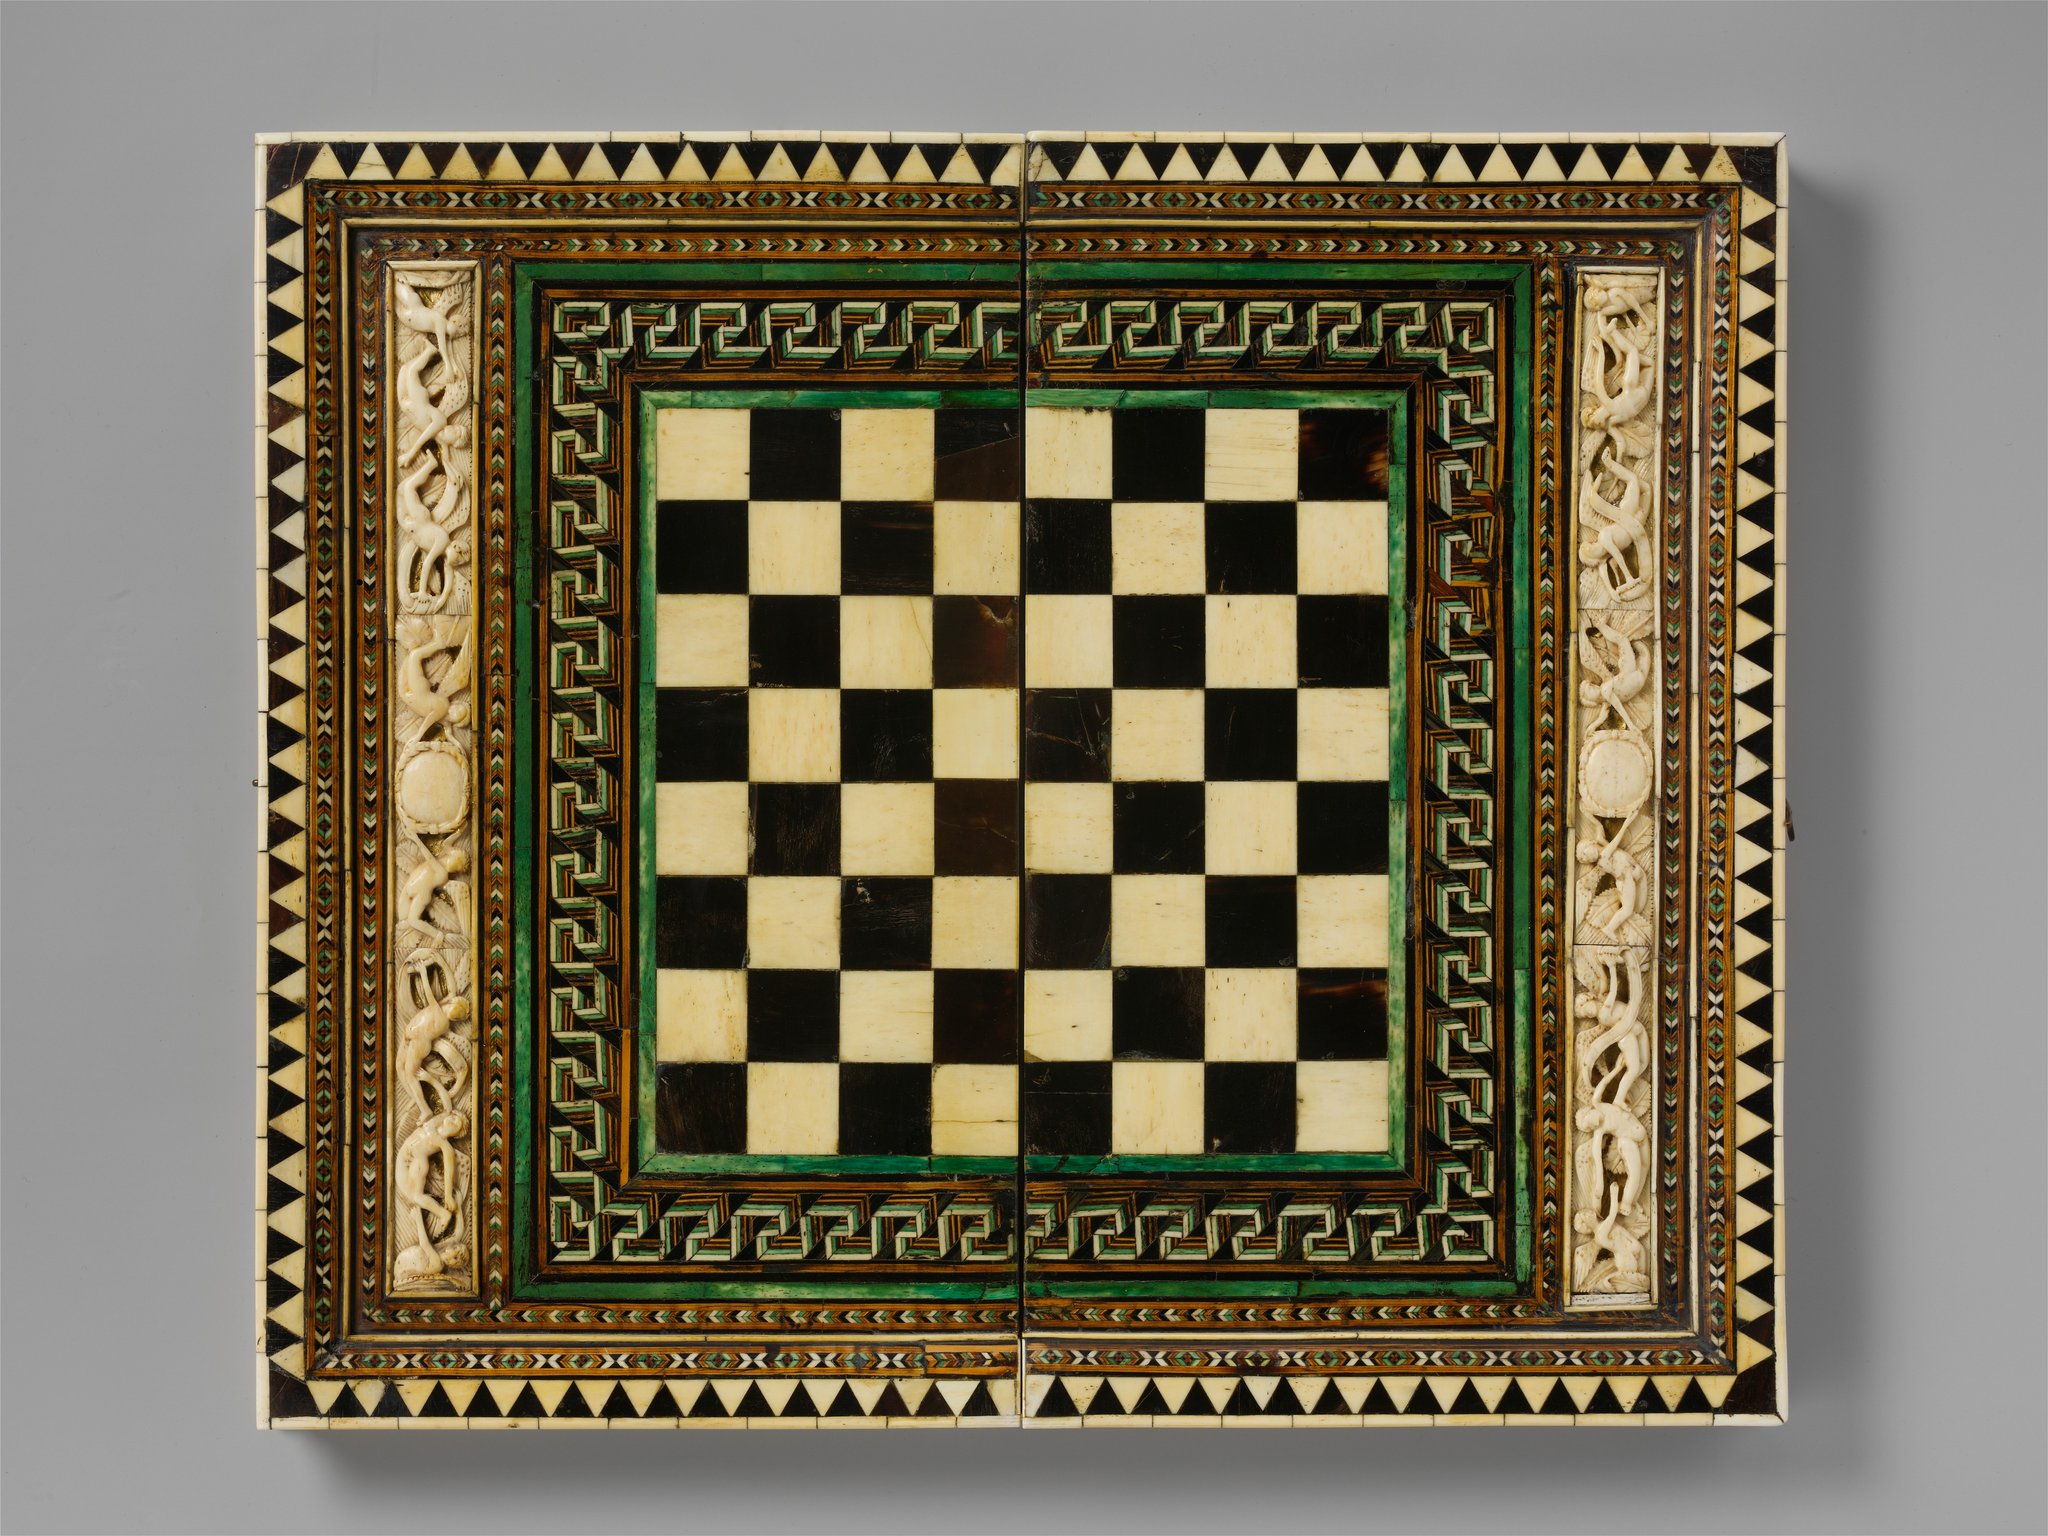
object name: gameboard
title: Game Board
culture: italian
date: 1401-1500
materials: bone, horn, metal, wood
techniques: gilding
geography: italy